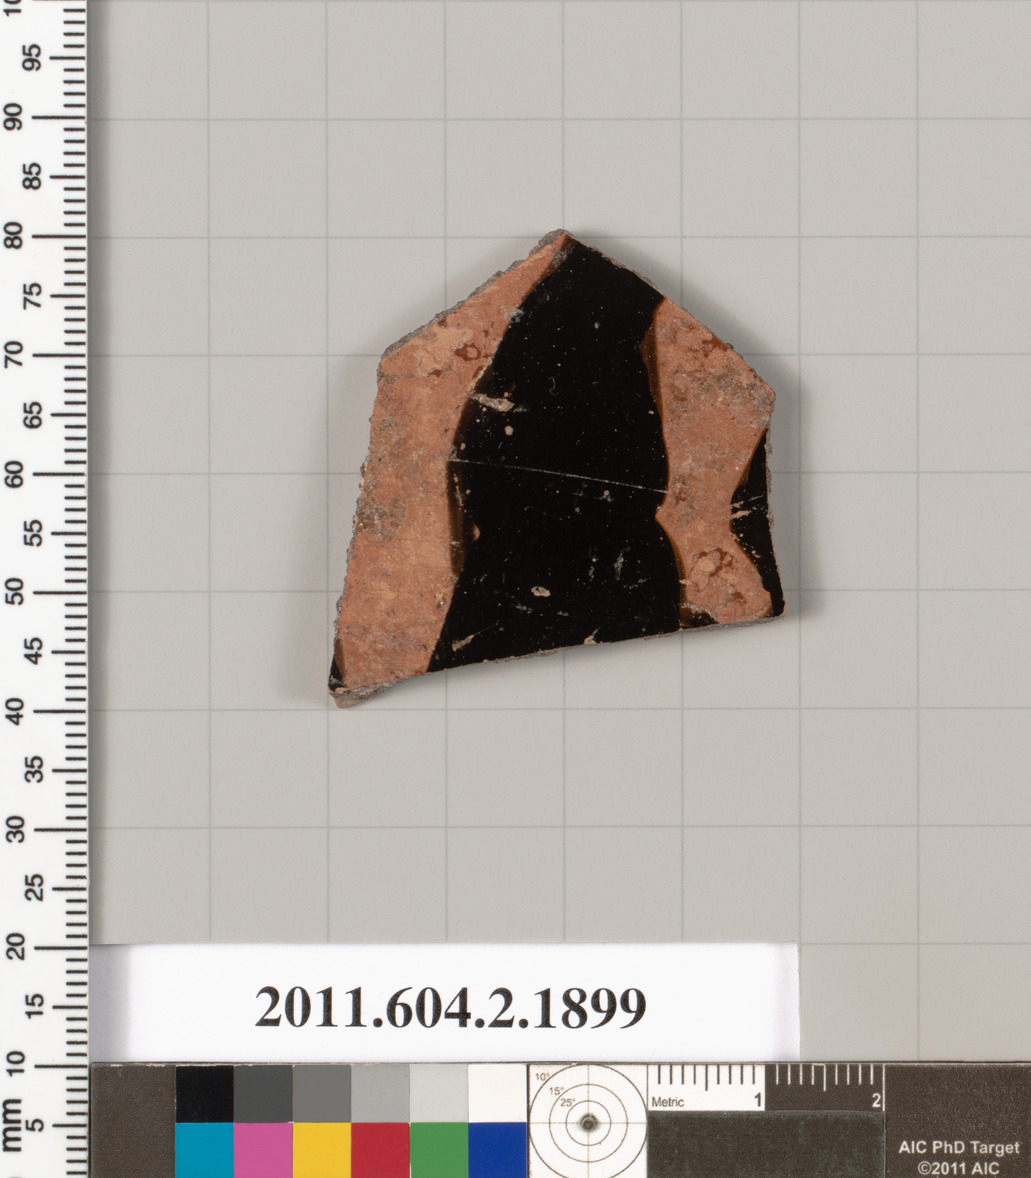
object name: skyphos fragment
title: Terracotta fragment of a skyphos (deep drinking cup)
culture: greek, attic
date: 440-420 BCE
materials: terracotta